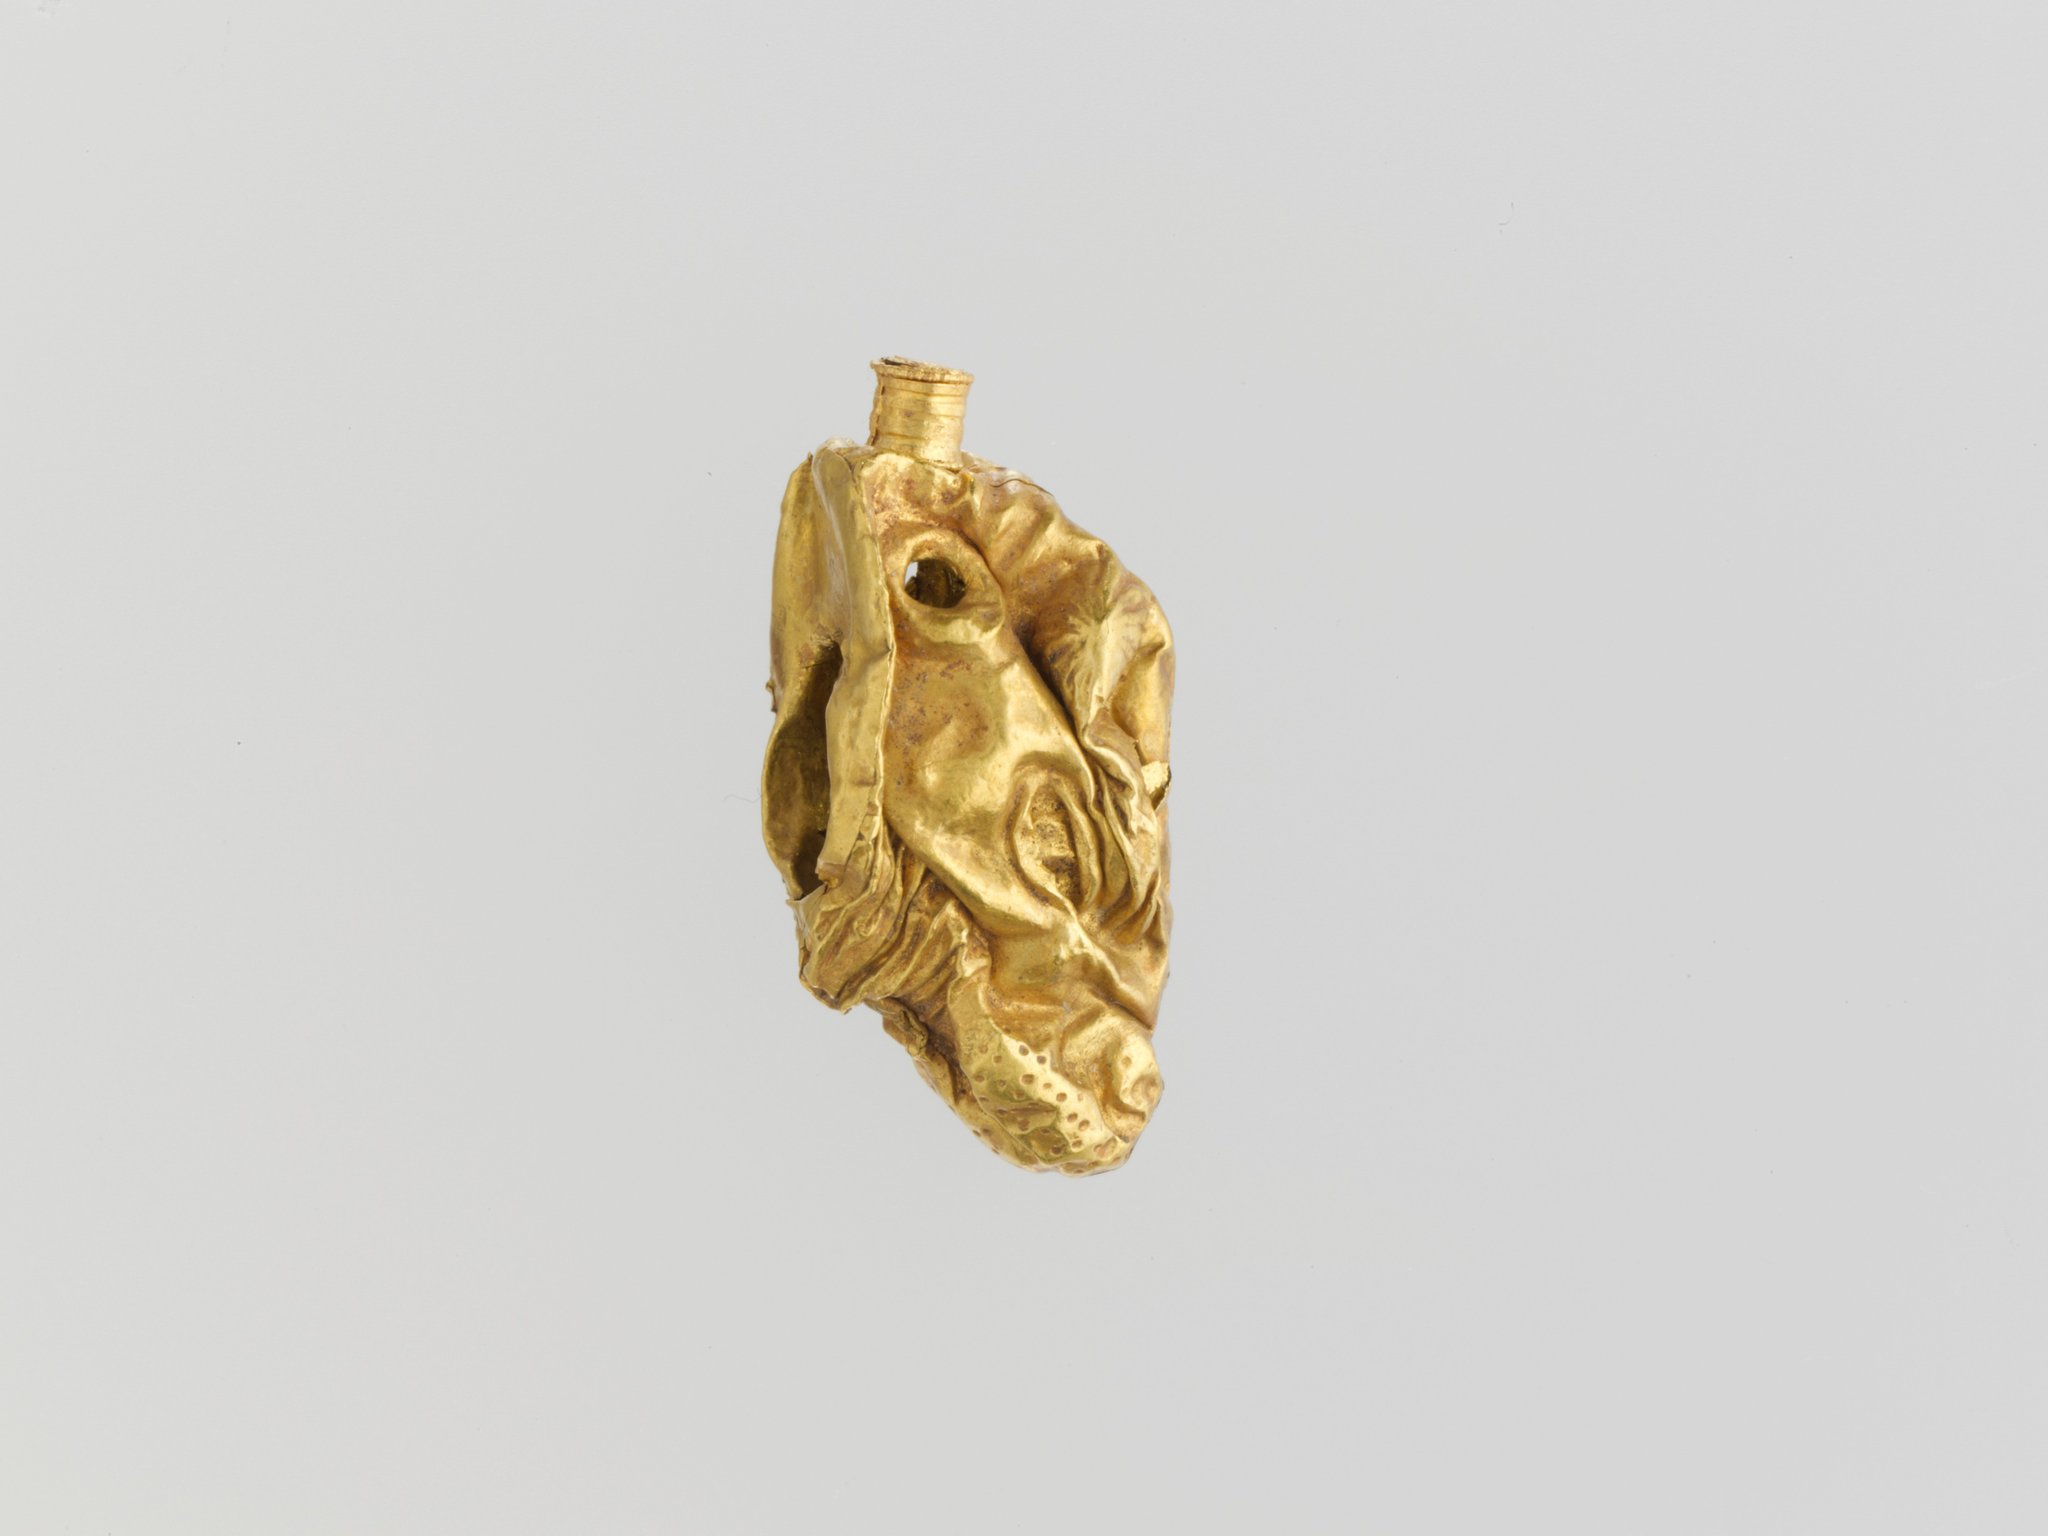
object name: pinhead or pendant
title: Gold pendant in the form of a bull's head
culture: cypriot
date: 1400-1050 BCE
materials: gold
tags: bulls